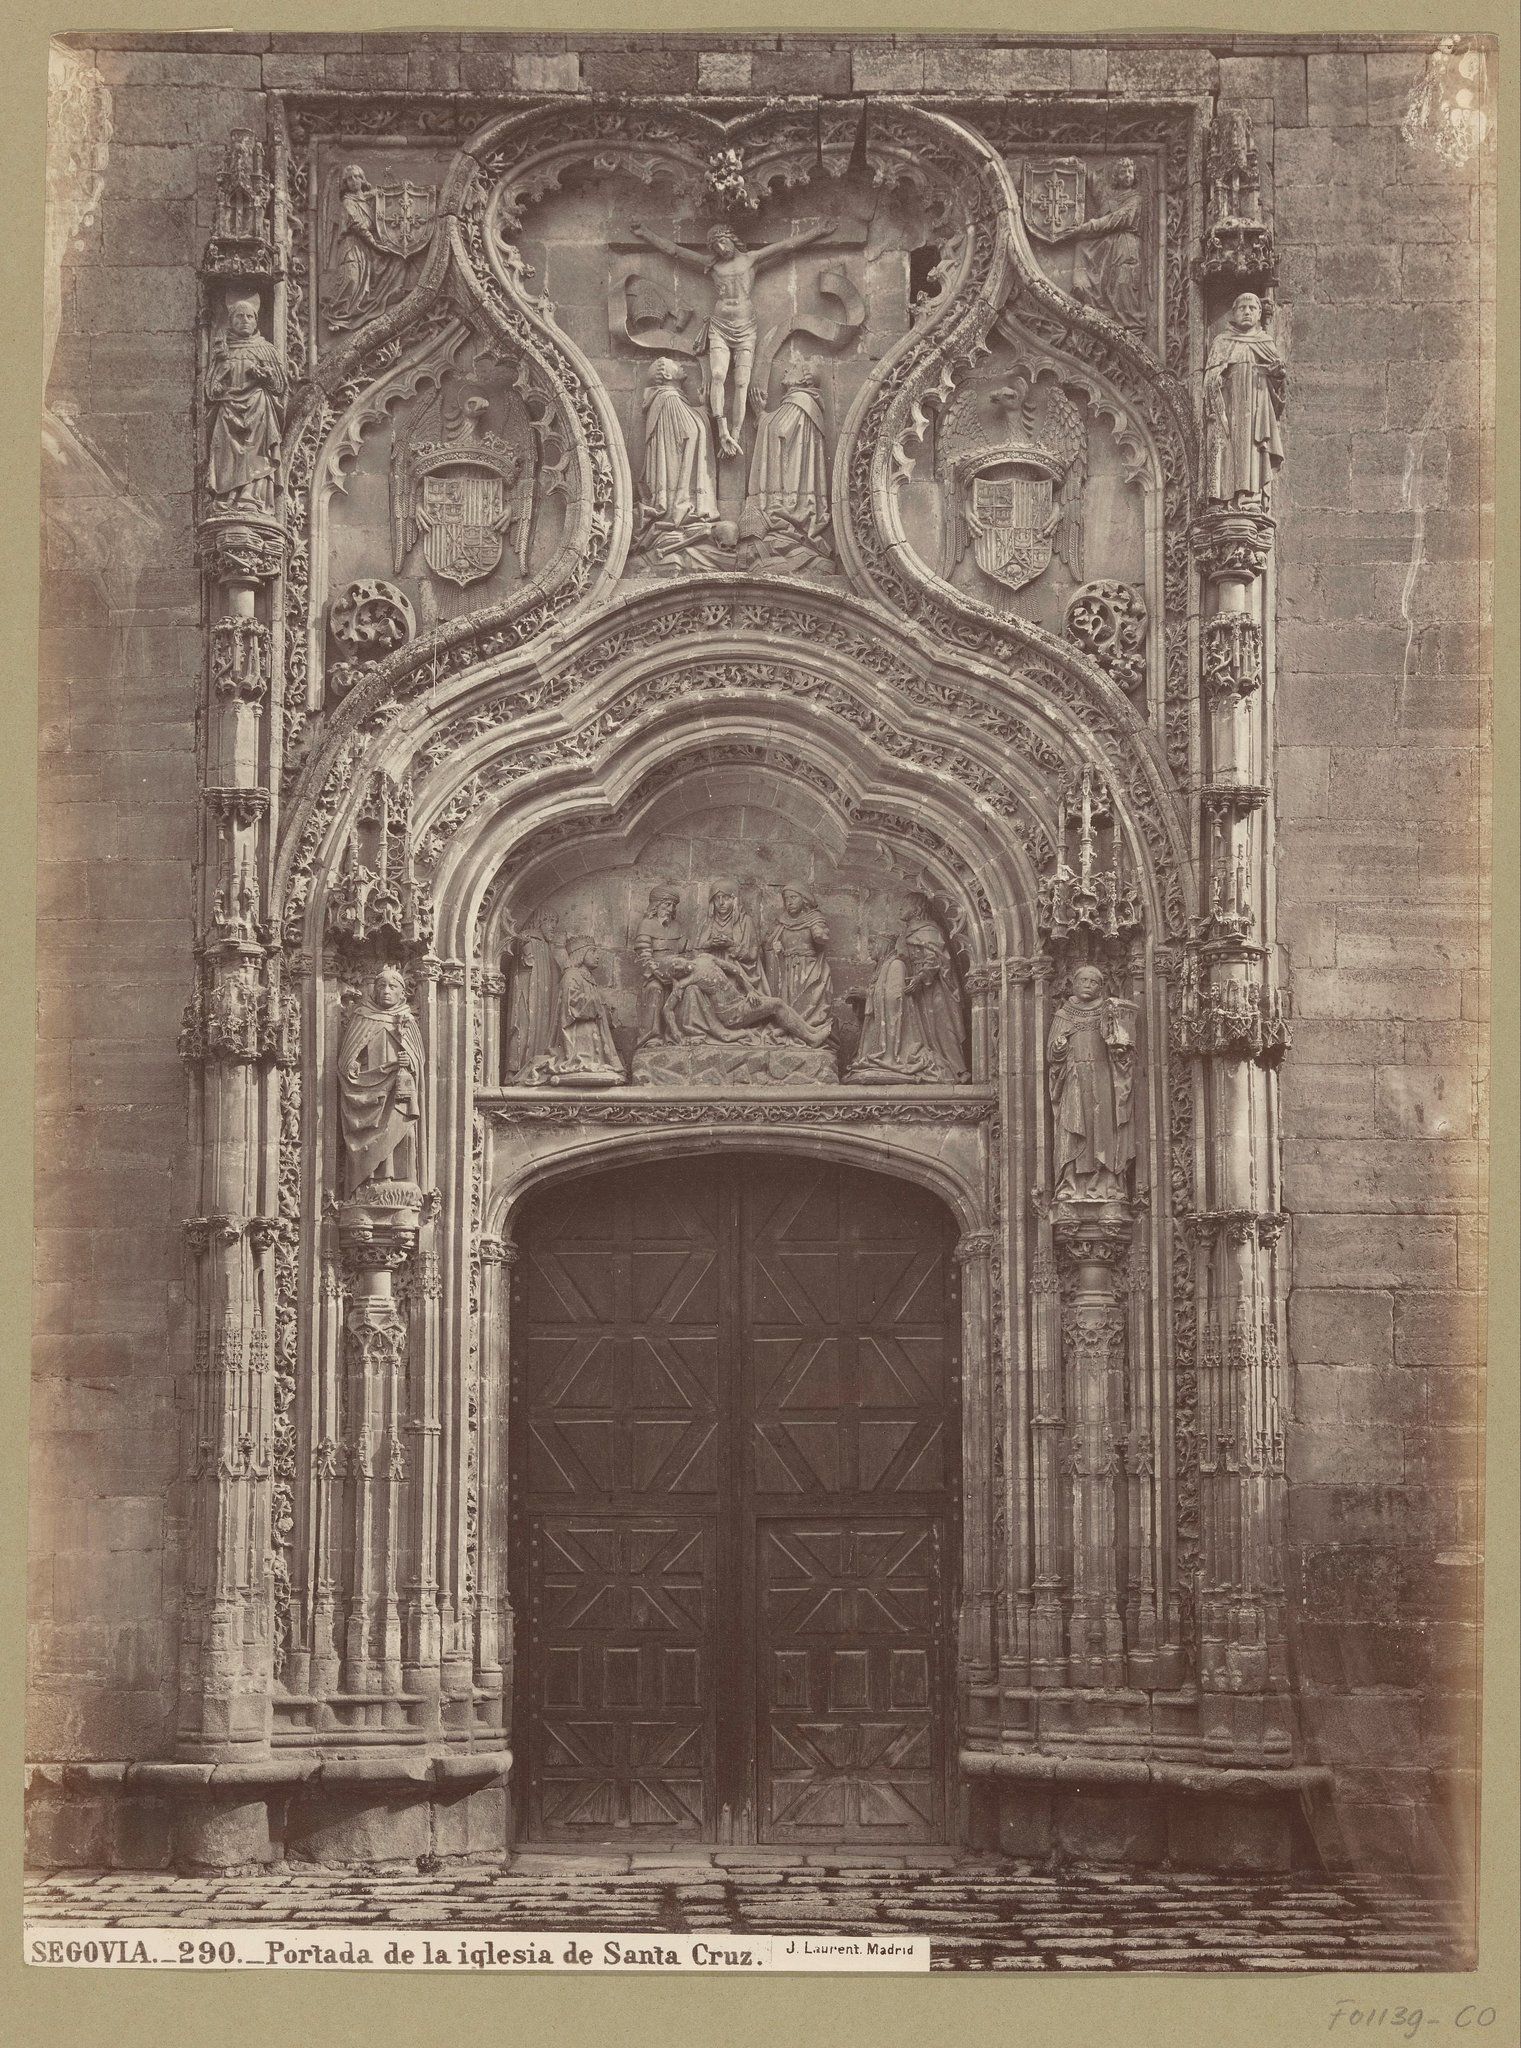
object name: album leaf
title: Portaal van de Santa Cruz la Real in Segovia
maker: juan laurent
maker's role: publisher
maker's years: 1816-1896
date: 1856-1863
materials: paper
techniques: albumen print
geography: segovia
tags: parts of church exterior and annexes: portal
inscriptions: number: ‘290.’